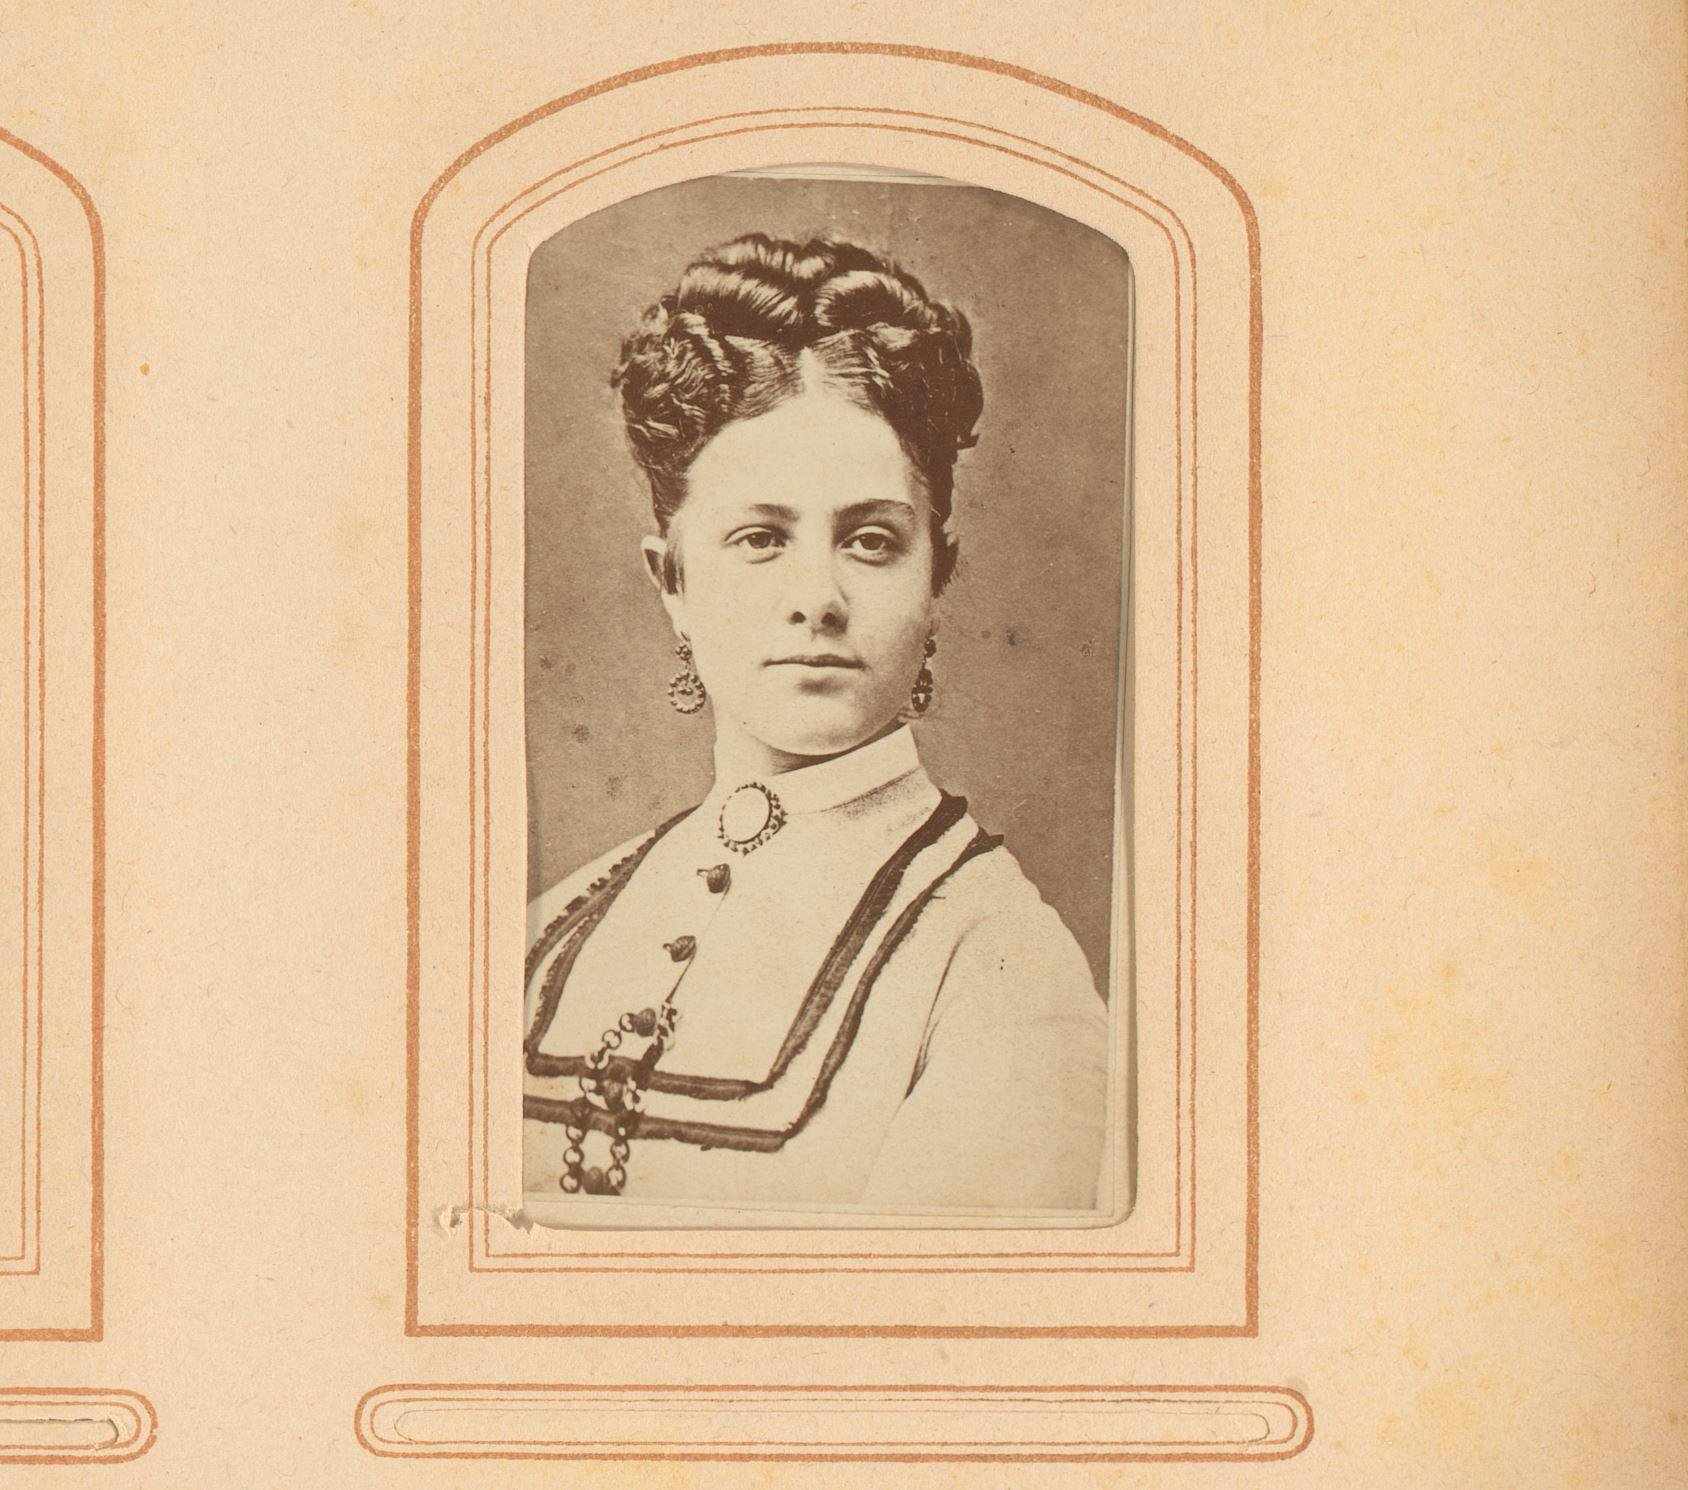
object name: photograph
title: Portret van Anna Charlotta Jansson ofwel Lotten Hellander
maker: Anonymous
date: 1850-1879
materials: cardboard, photographic support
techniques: albumen print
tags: historical persons, portrait of actor, actress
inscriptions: annotation: ‘Lotten Hellander/ [...] Jansson/ 1851-1879’